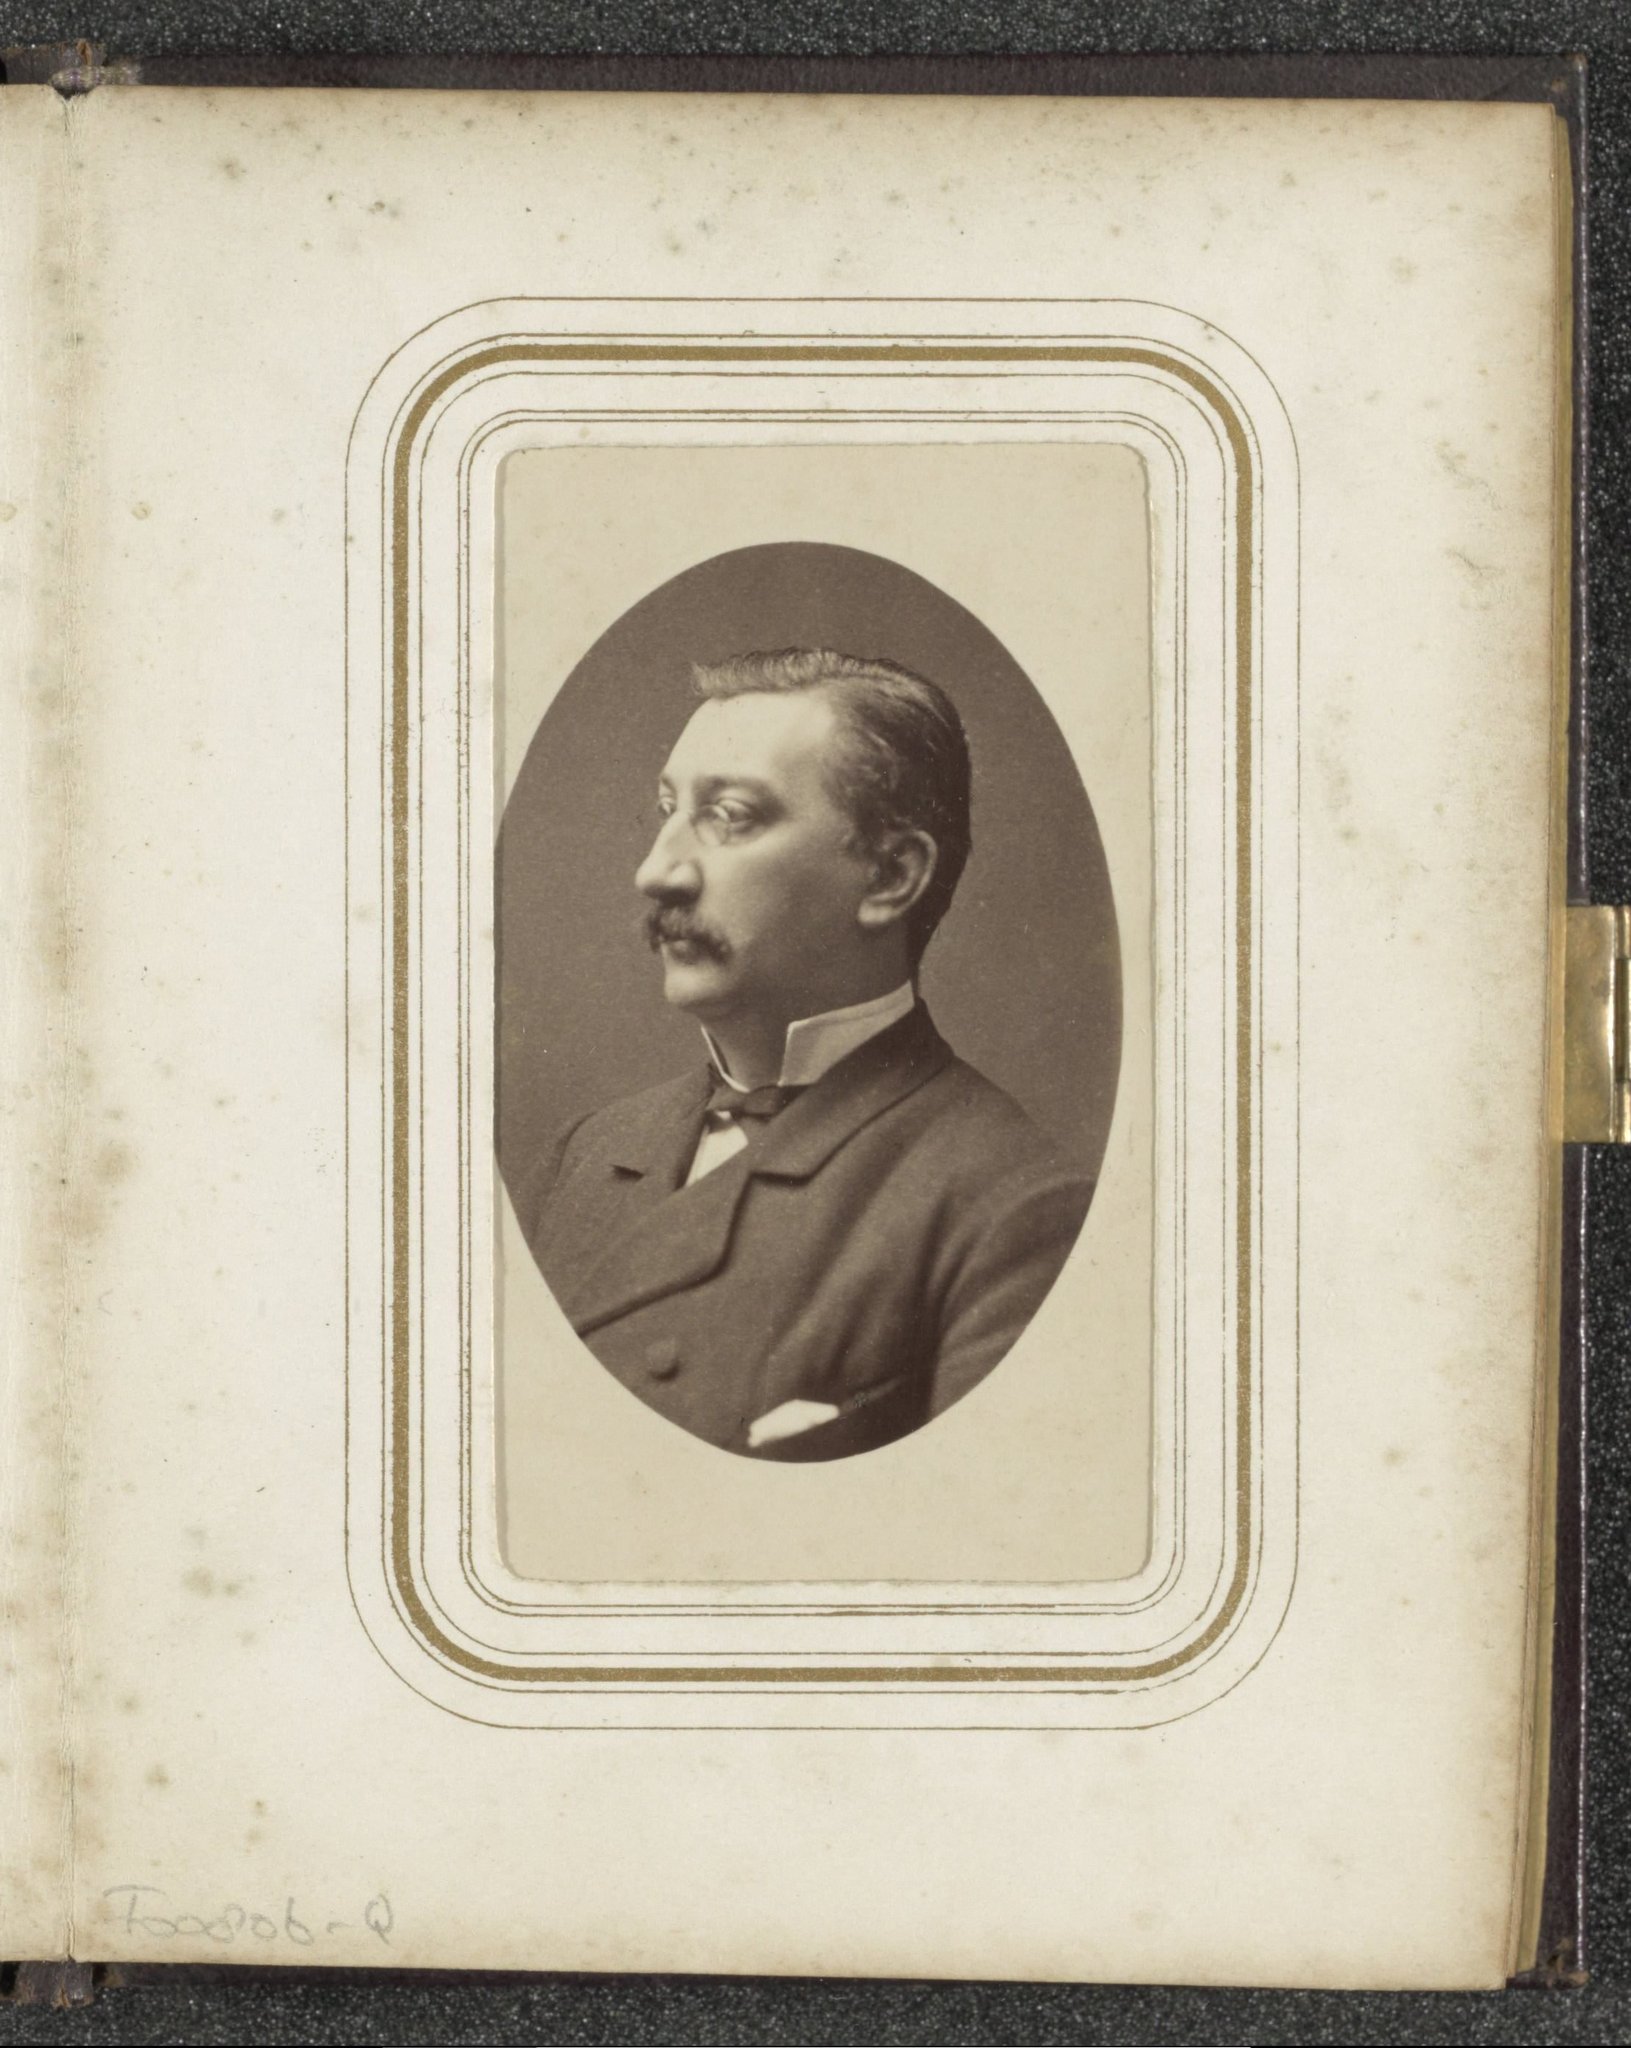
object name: carte de visite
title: Portret van een man met een snor en een bril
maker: marius n.f. rotteveel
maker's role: fotograaf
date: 1881-1887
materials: cardboard, paper, photographic support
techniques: albumen print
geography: haarlem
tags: eyeglasses, spectacles, moustache, historical persons, clothing for the upper part of the body, hairdress, neck-gear: collar, haarlem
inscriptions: address: ‘71 Spaarne 71 tegen over de Oude gracht, Haarlem.’, address: ‘Haarlem’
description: Onderdeel van Fotoalbum met 36 cartes-de-visite van Nederlandse personen.